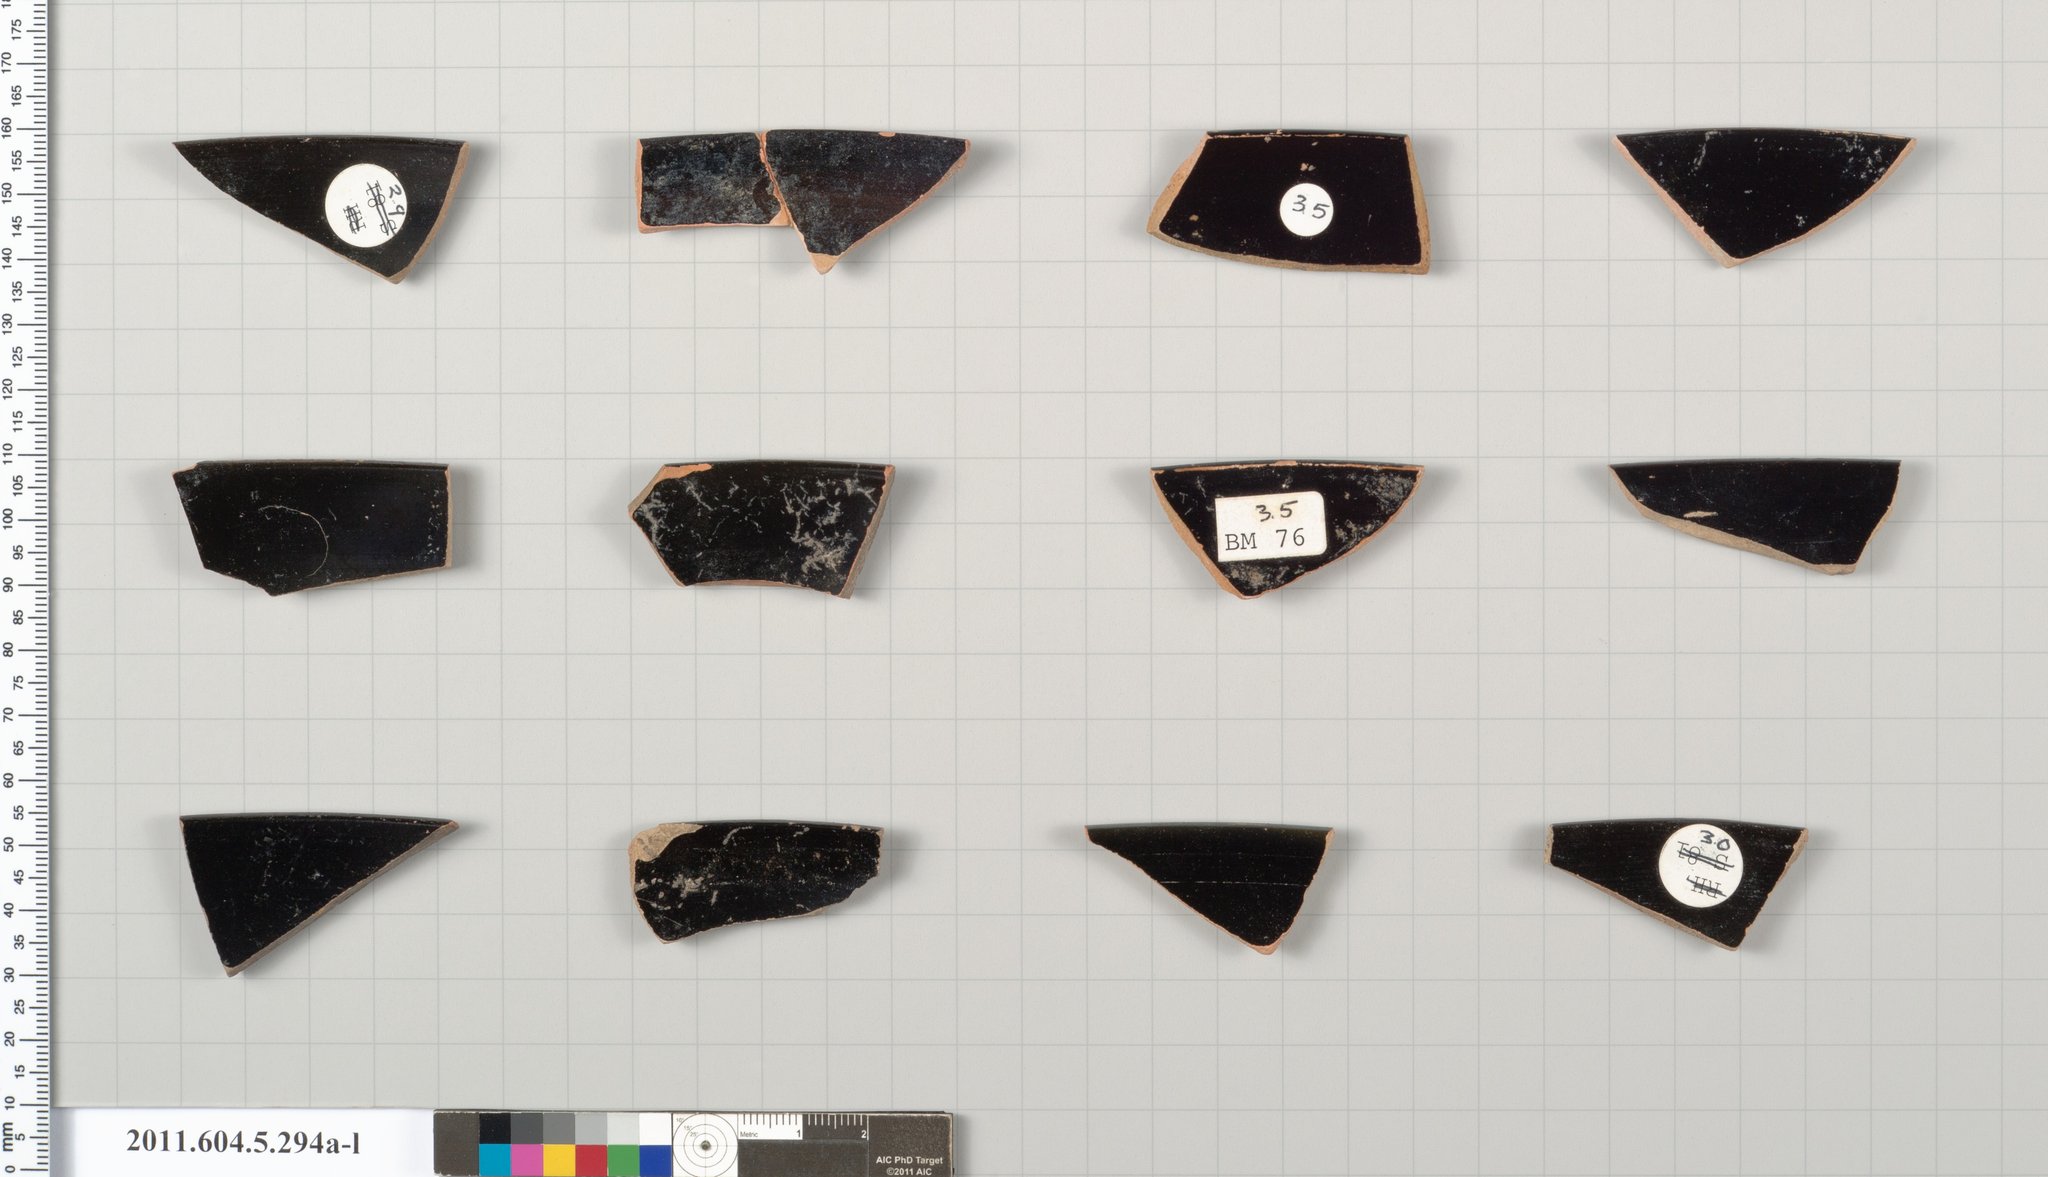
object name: kylix fragment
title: Terracotta rim fragments of kylikes (drinking cups)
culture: greek, attic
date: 600-401 BCE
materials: terracotta